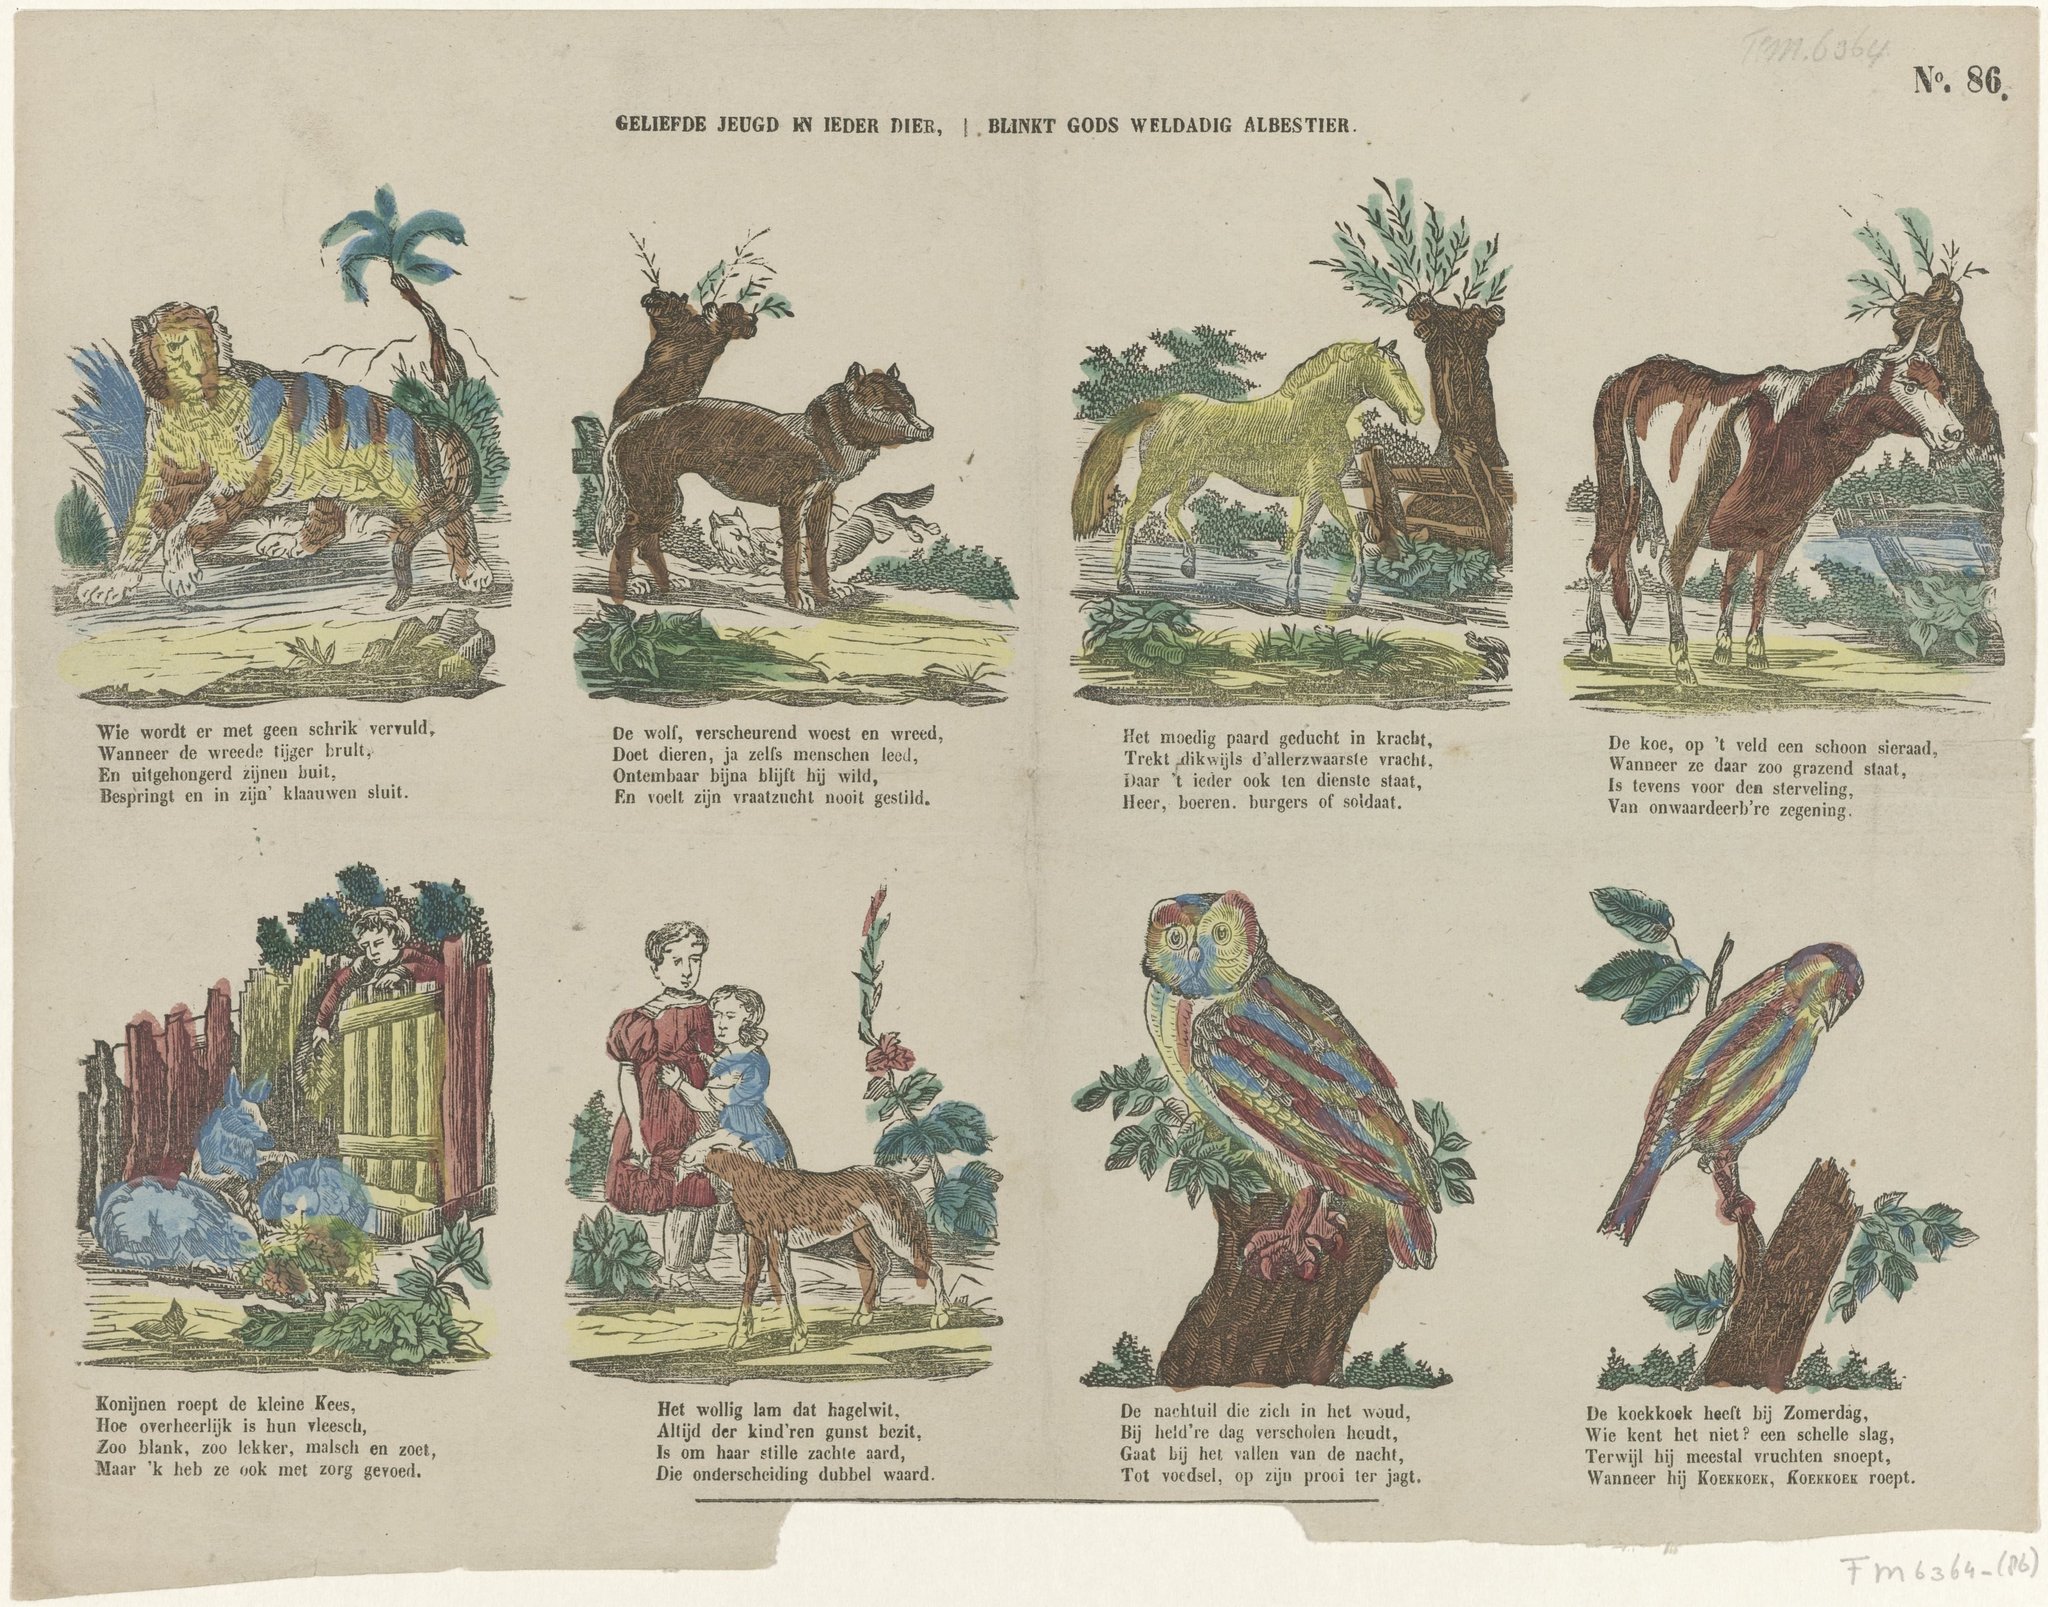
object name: popular print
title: Geliefde jeugd in ieder dier / blinkt Gods weldadig albestier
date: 1850-1870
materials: paper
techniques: colour, letterpress printing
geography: netherlands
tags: animals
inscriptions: collector's mark: Lugt 2228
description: Blad met acht voorstellingen van dieren. Onder elk plaatje een vierregelig versje. Genummerd rechtsboven: No. 86. Ca. 1800-1850.